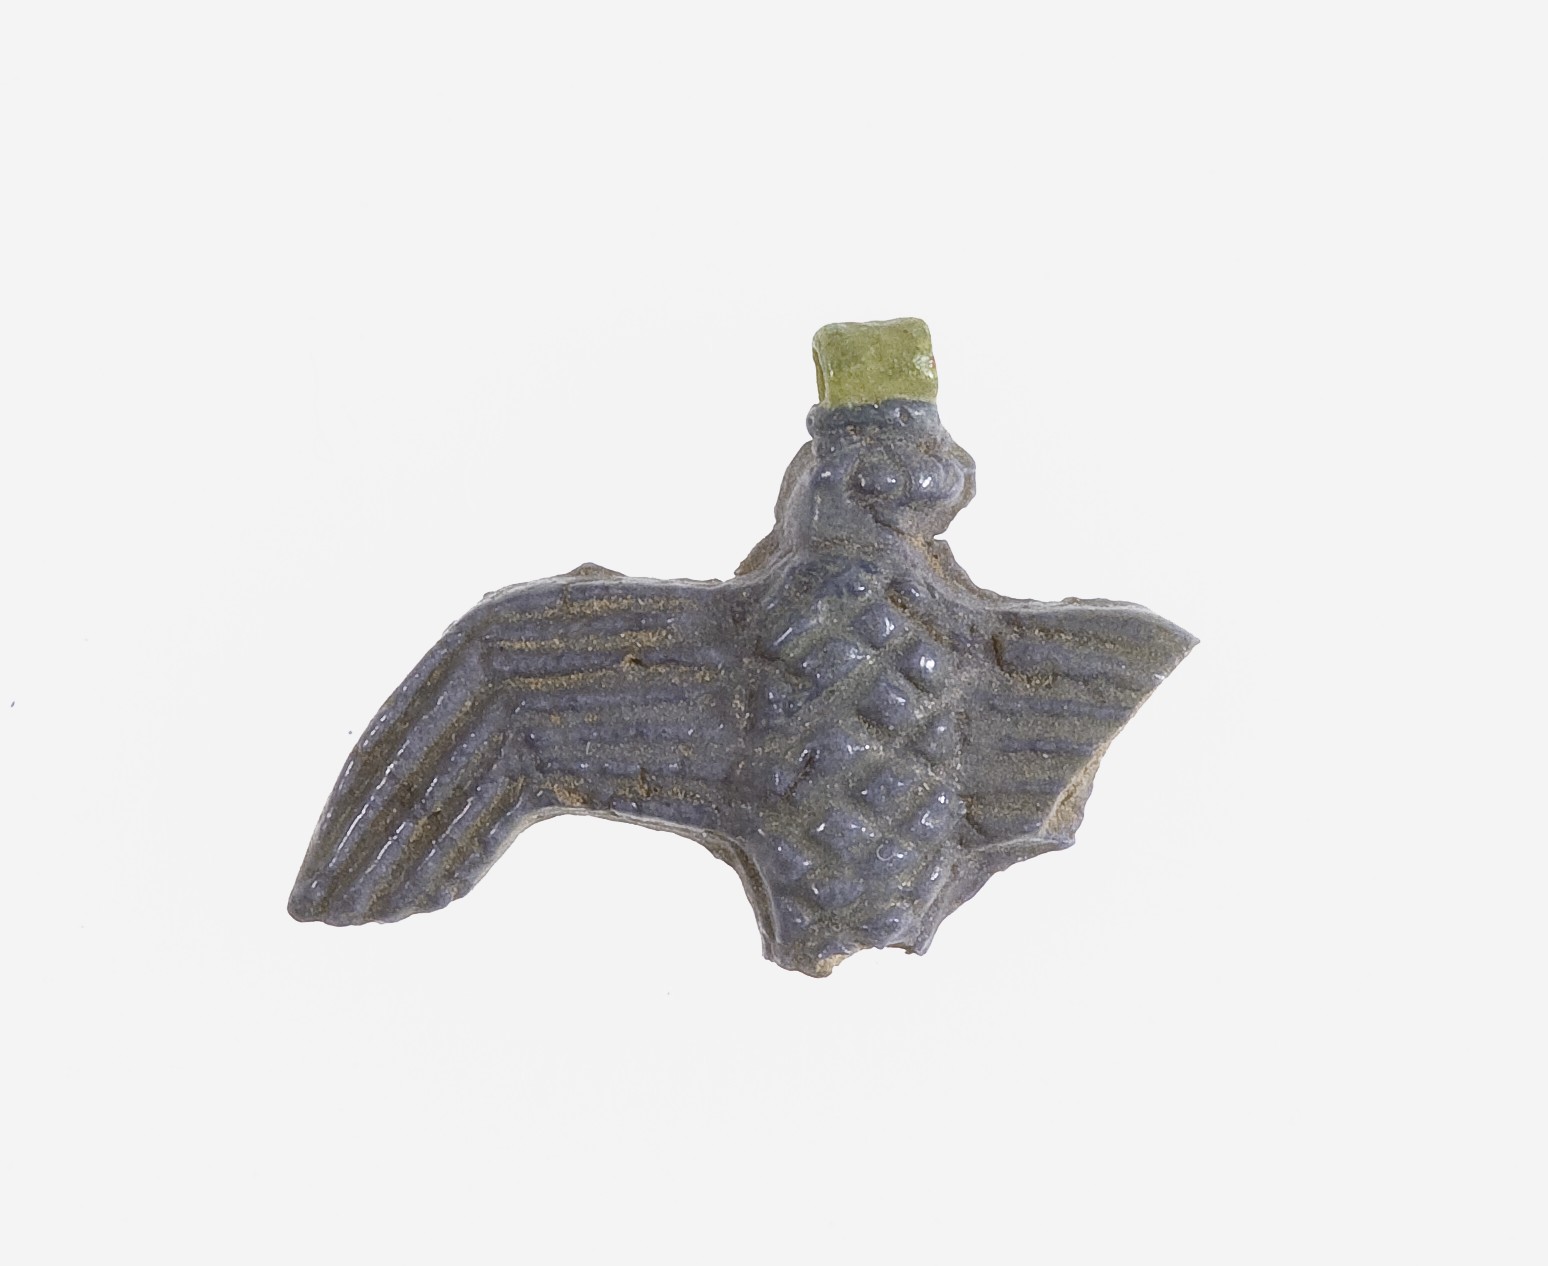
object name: amulet, falcon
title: Falcon Amulet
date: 1390-1352 BCE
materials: faience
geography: egypt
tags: falcons